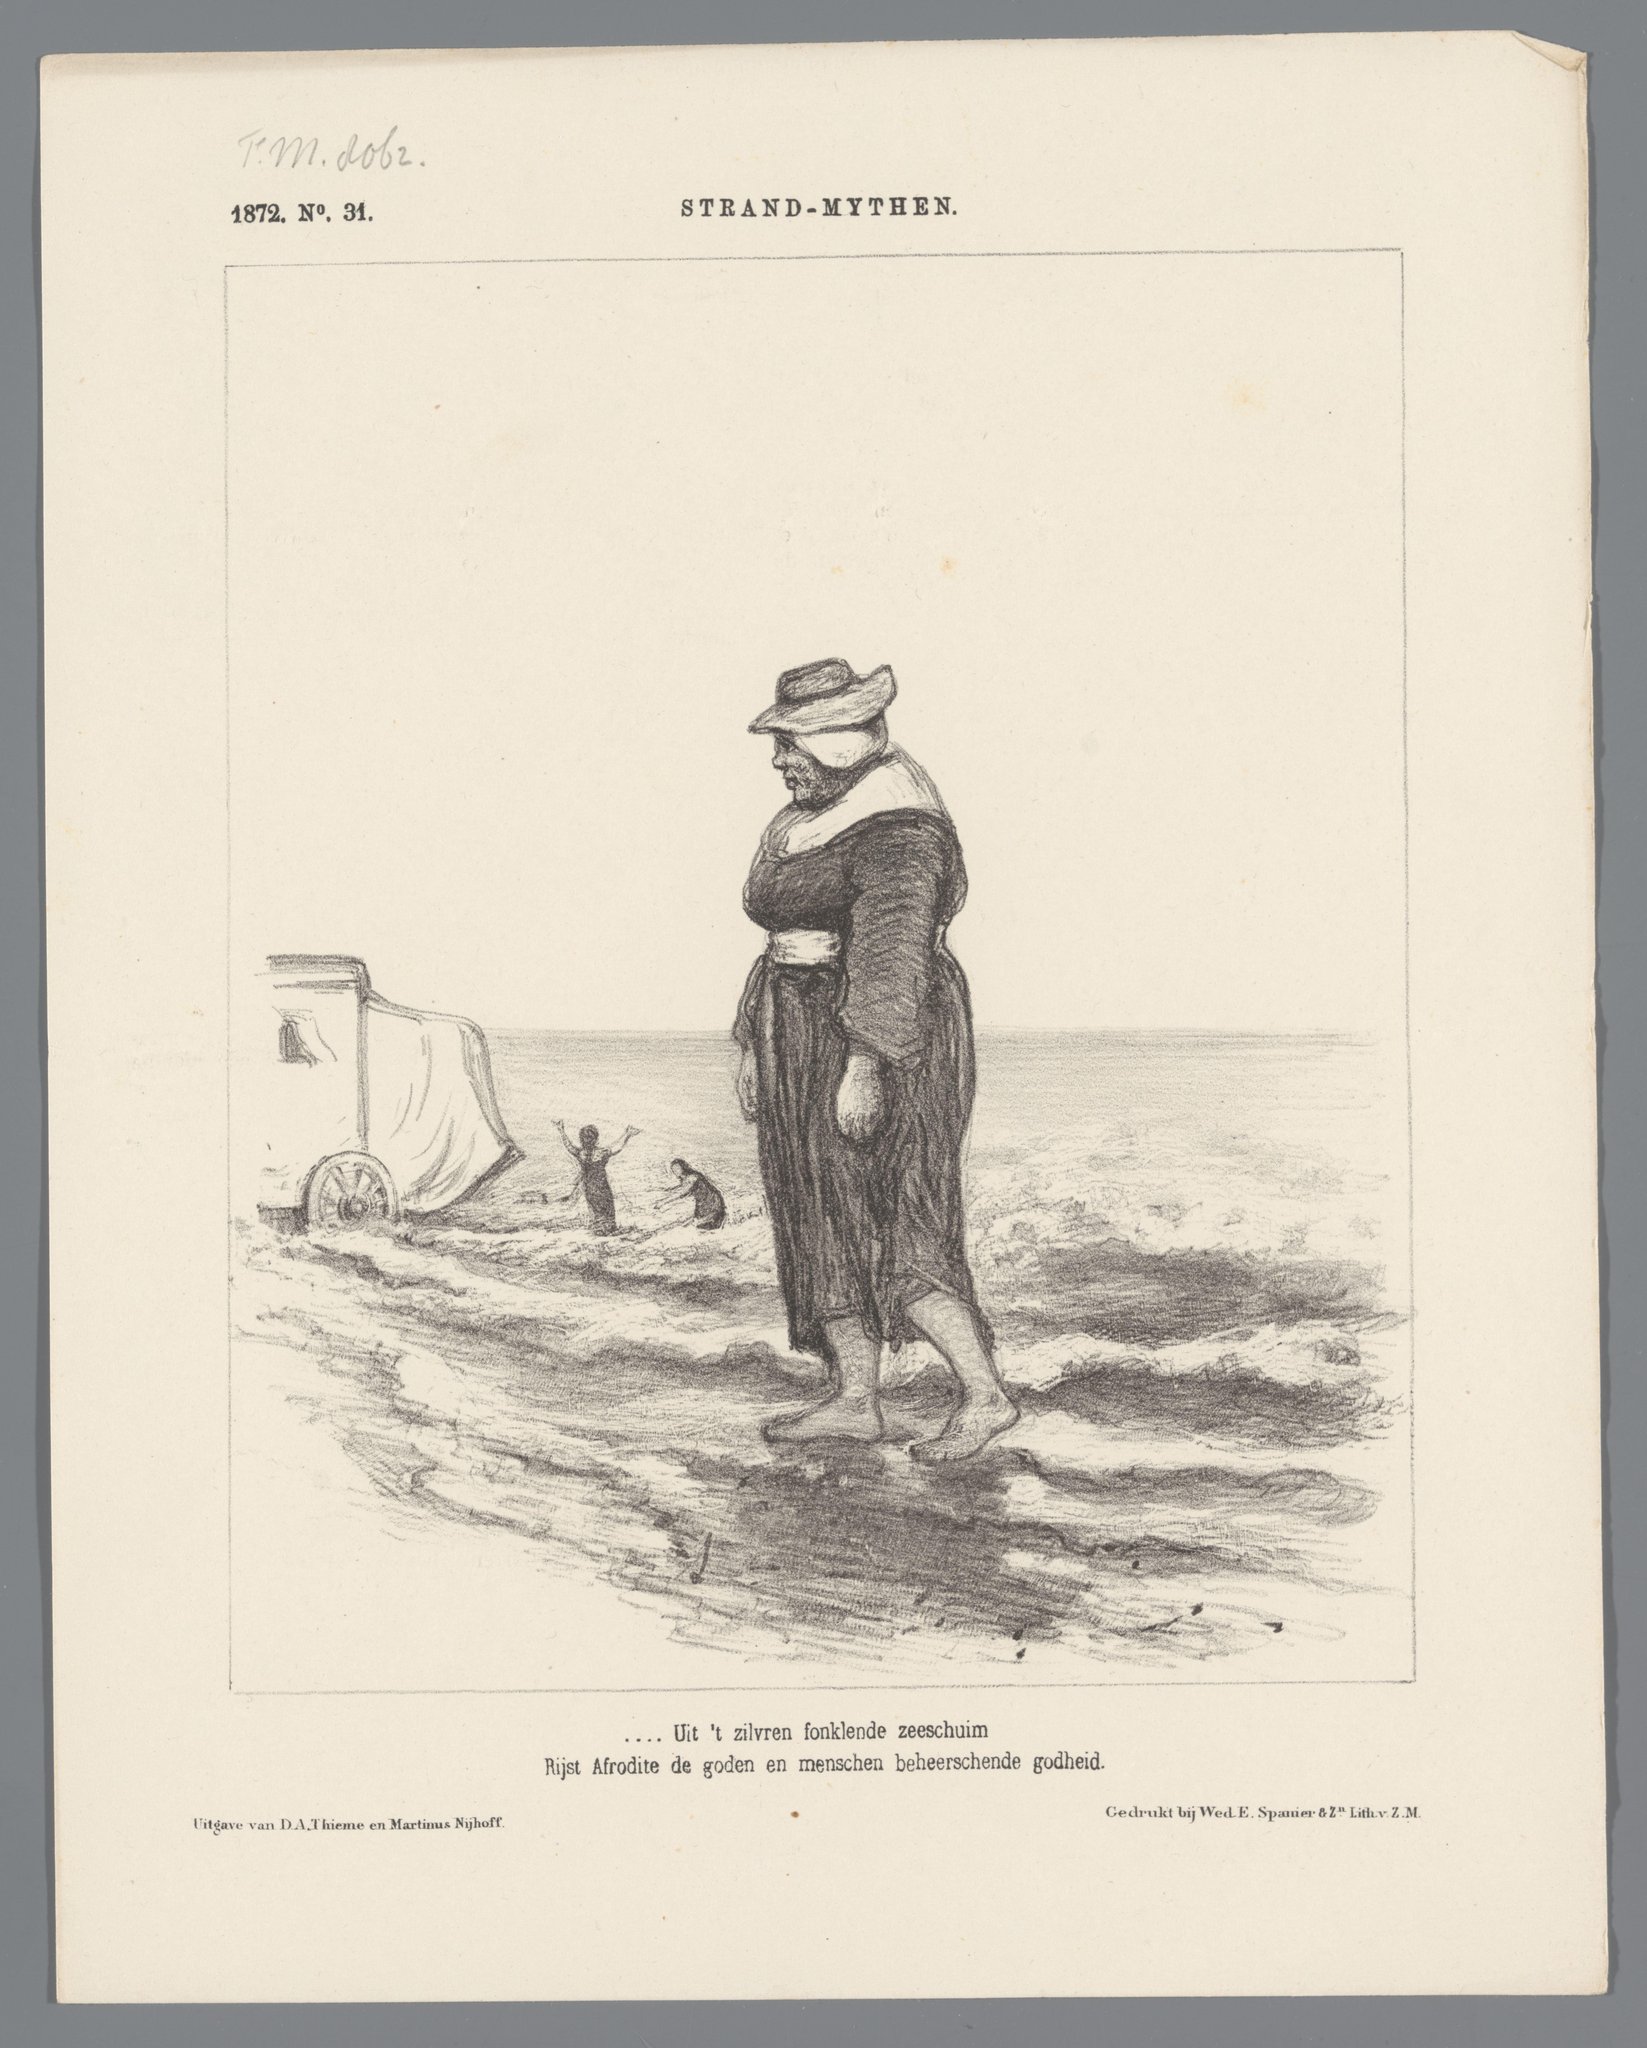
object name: cartoon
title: Strand-mythen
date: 1872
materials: paper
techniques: lithograph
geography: netherlands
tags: birth of venus; venus anadyomene: after uranus' castration venus rises from the sea wringing the water from her hair; usually she is awaited by the hours, in or beside the water (on the beach)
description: Spotprent met een forse Scheveningse badgast als Venus uit het zeewater rijzende. Plaat verschenen bij het weekblad De Nederlandsche Spectator, nr. 31, 1872.